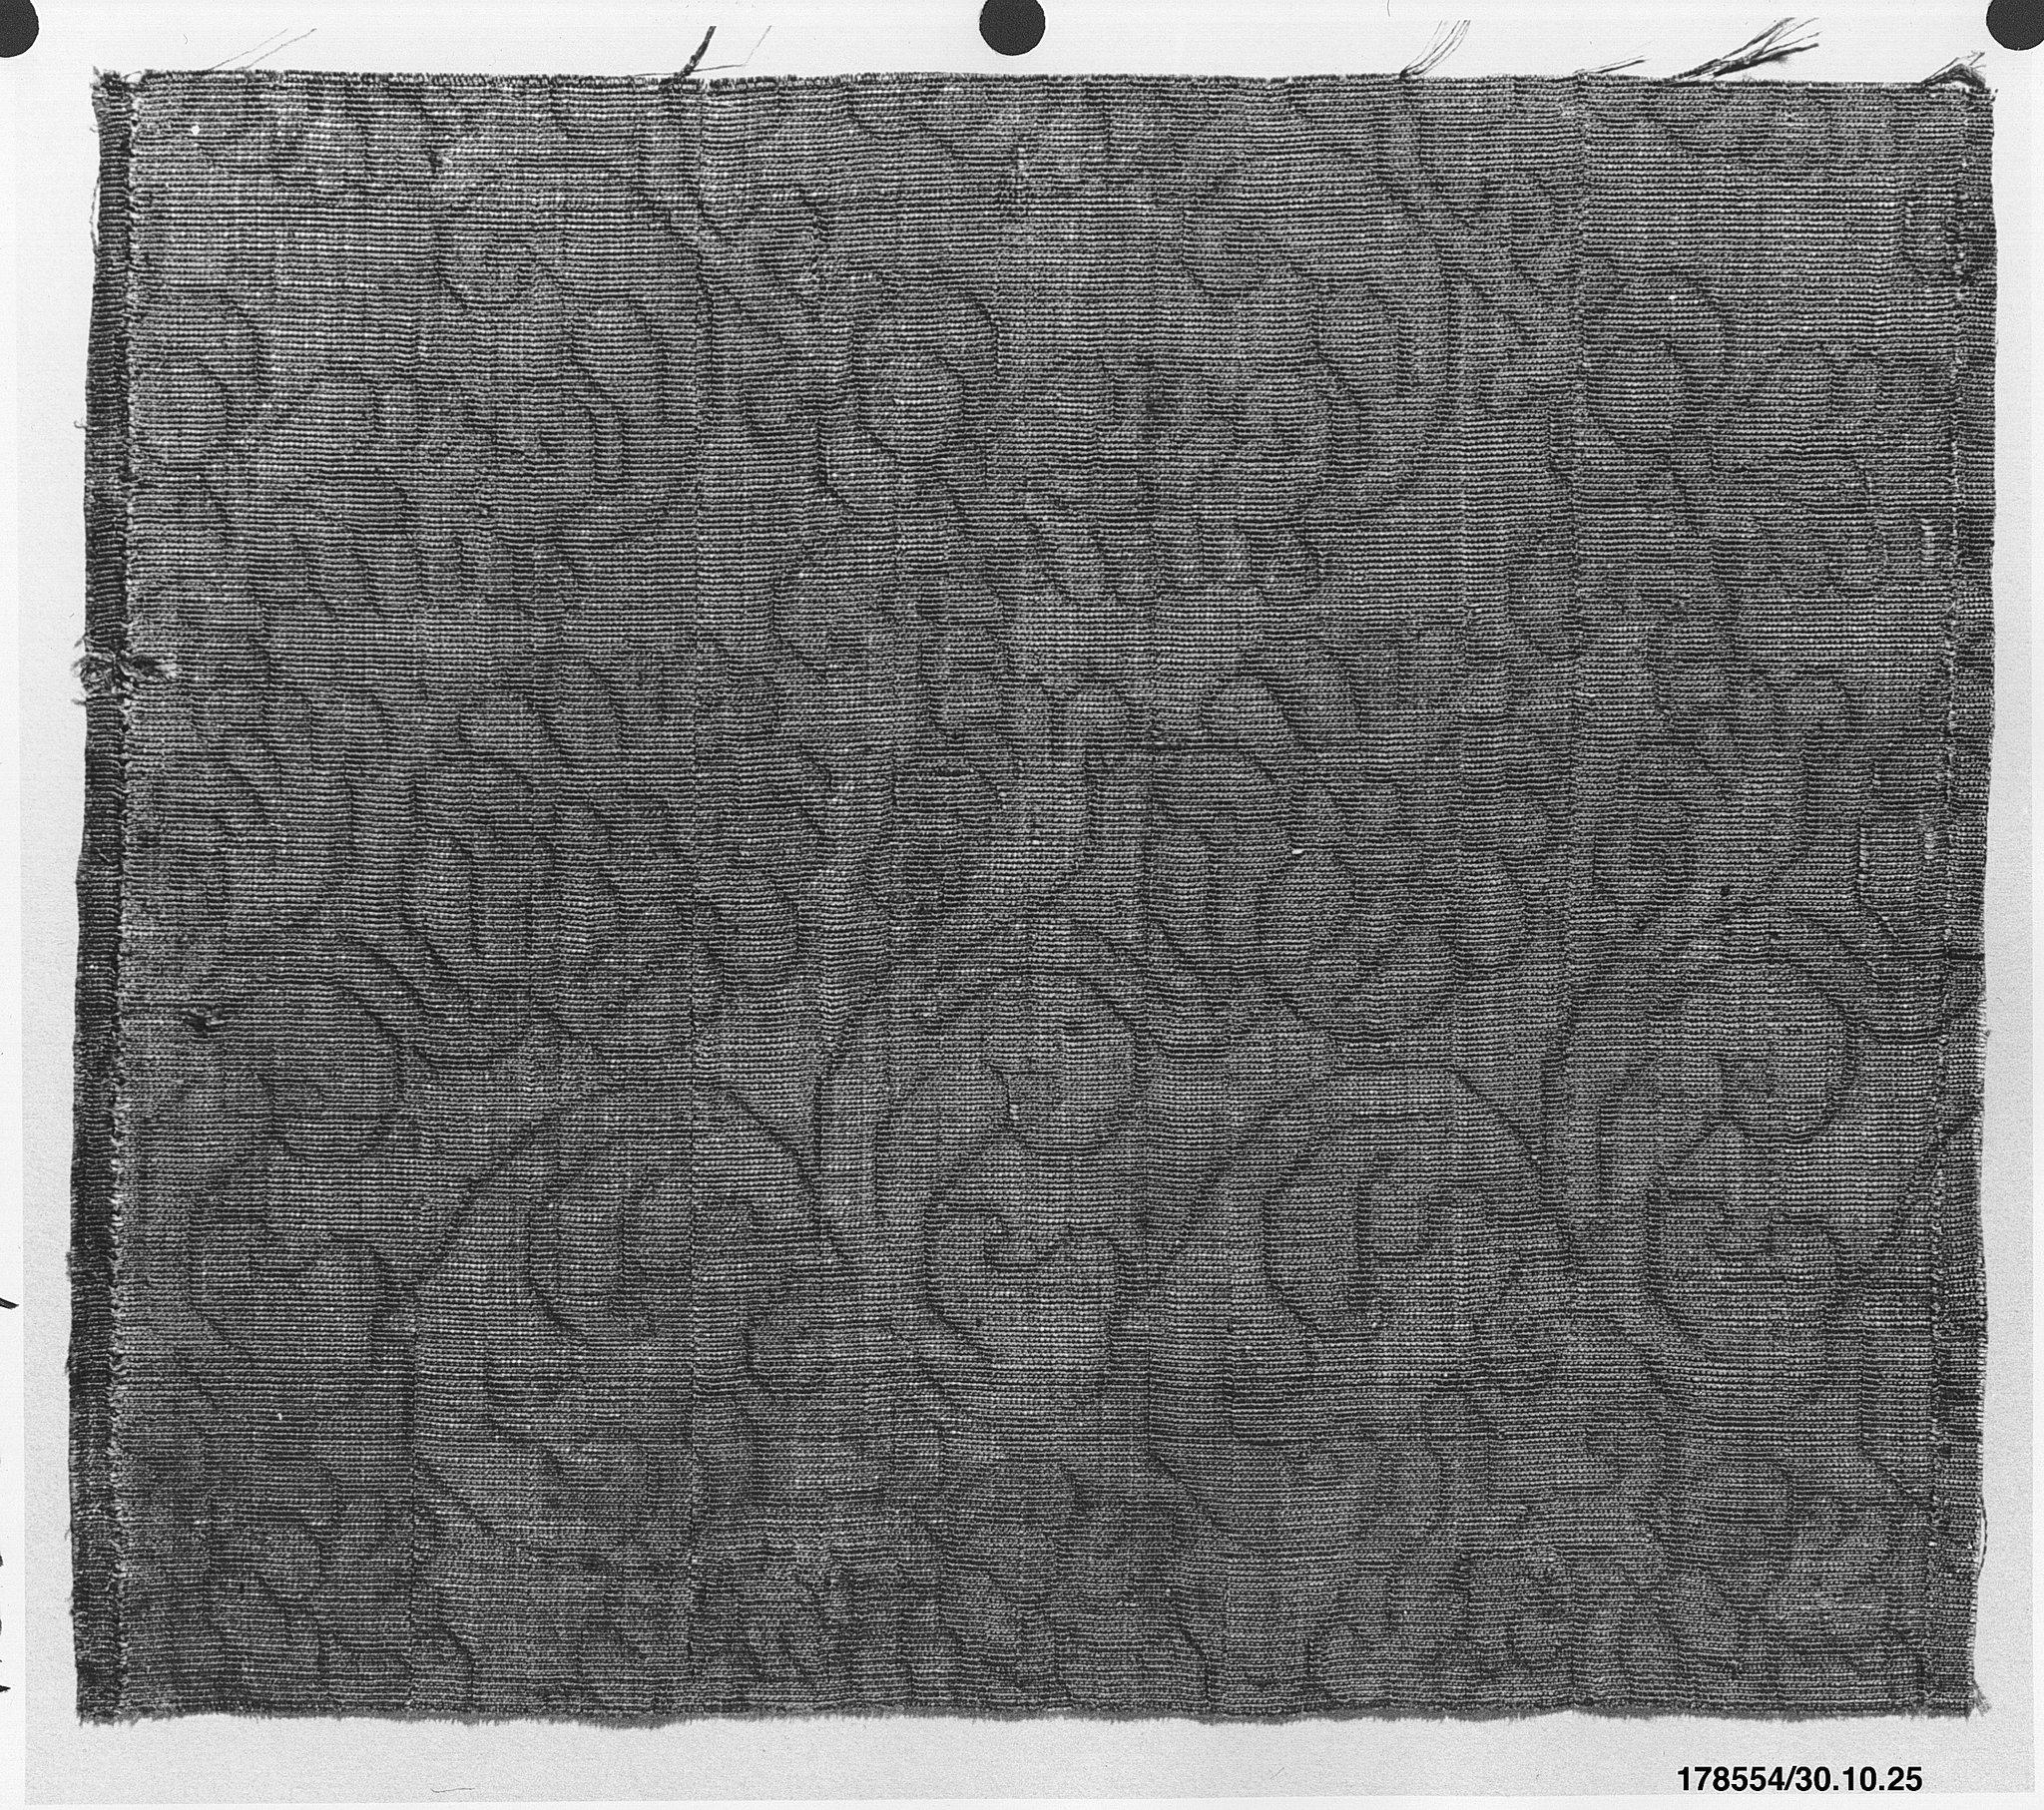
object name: piece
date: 1601-1700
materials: metal thread, silk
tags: flowers